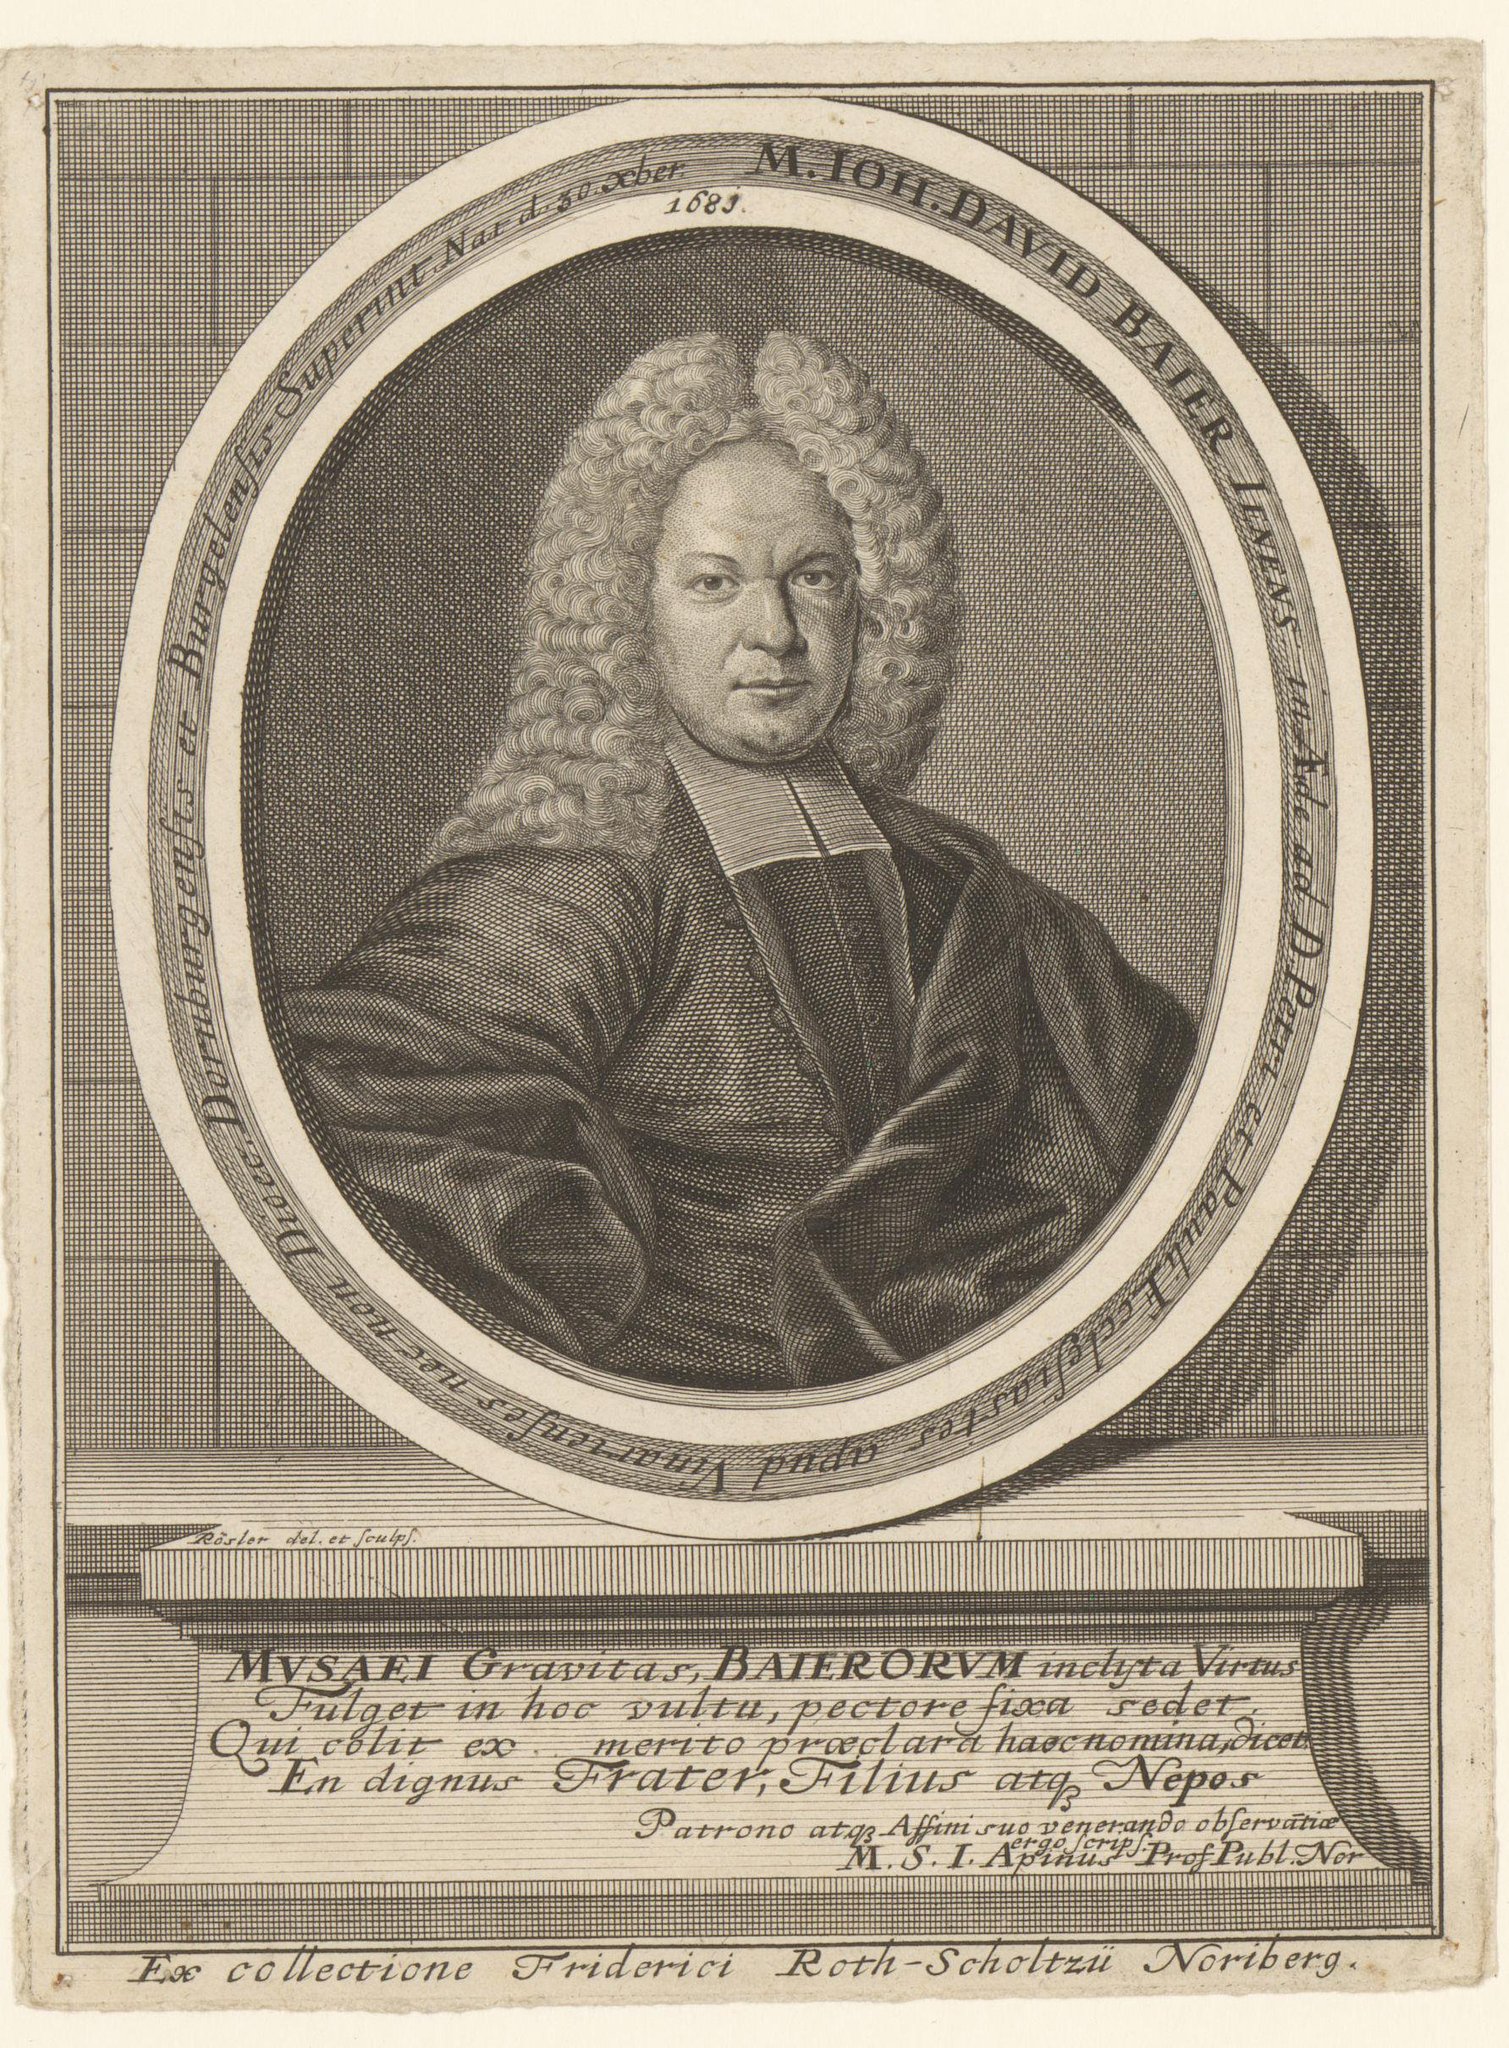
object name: print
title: Portret van Johann David Baier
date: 1715-1777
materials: paper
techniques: engraving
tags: publisher, historical persons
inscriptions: collector's mark: Lugt 2228